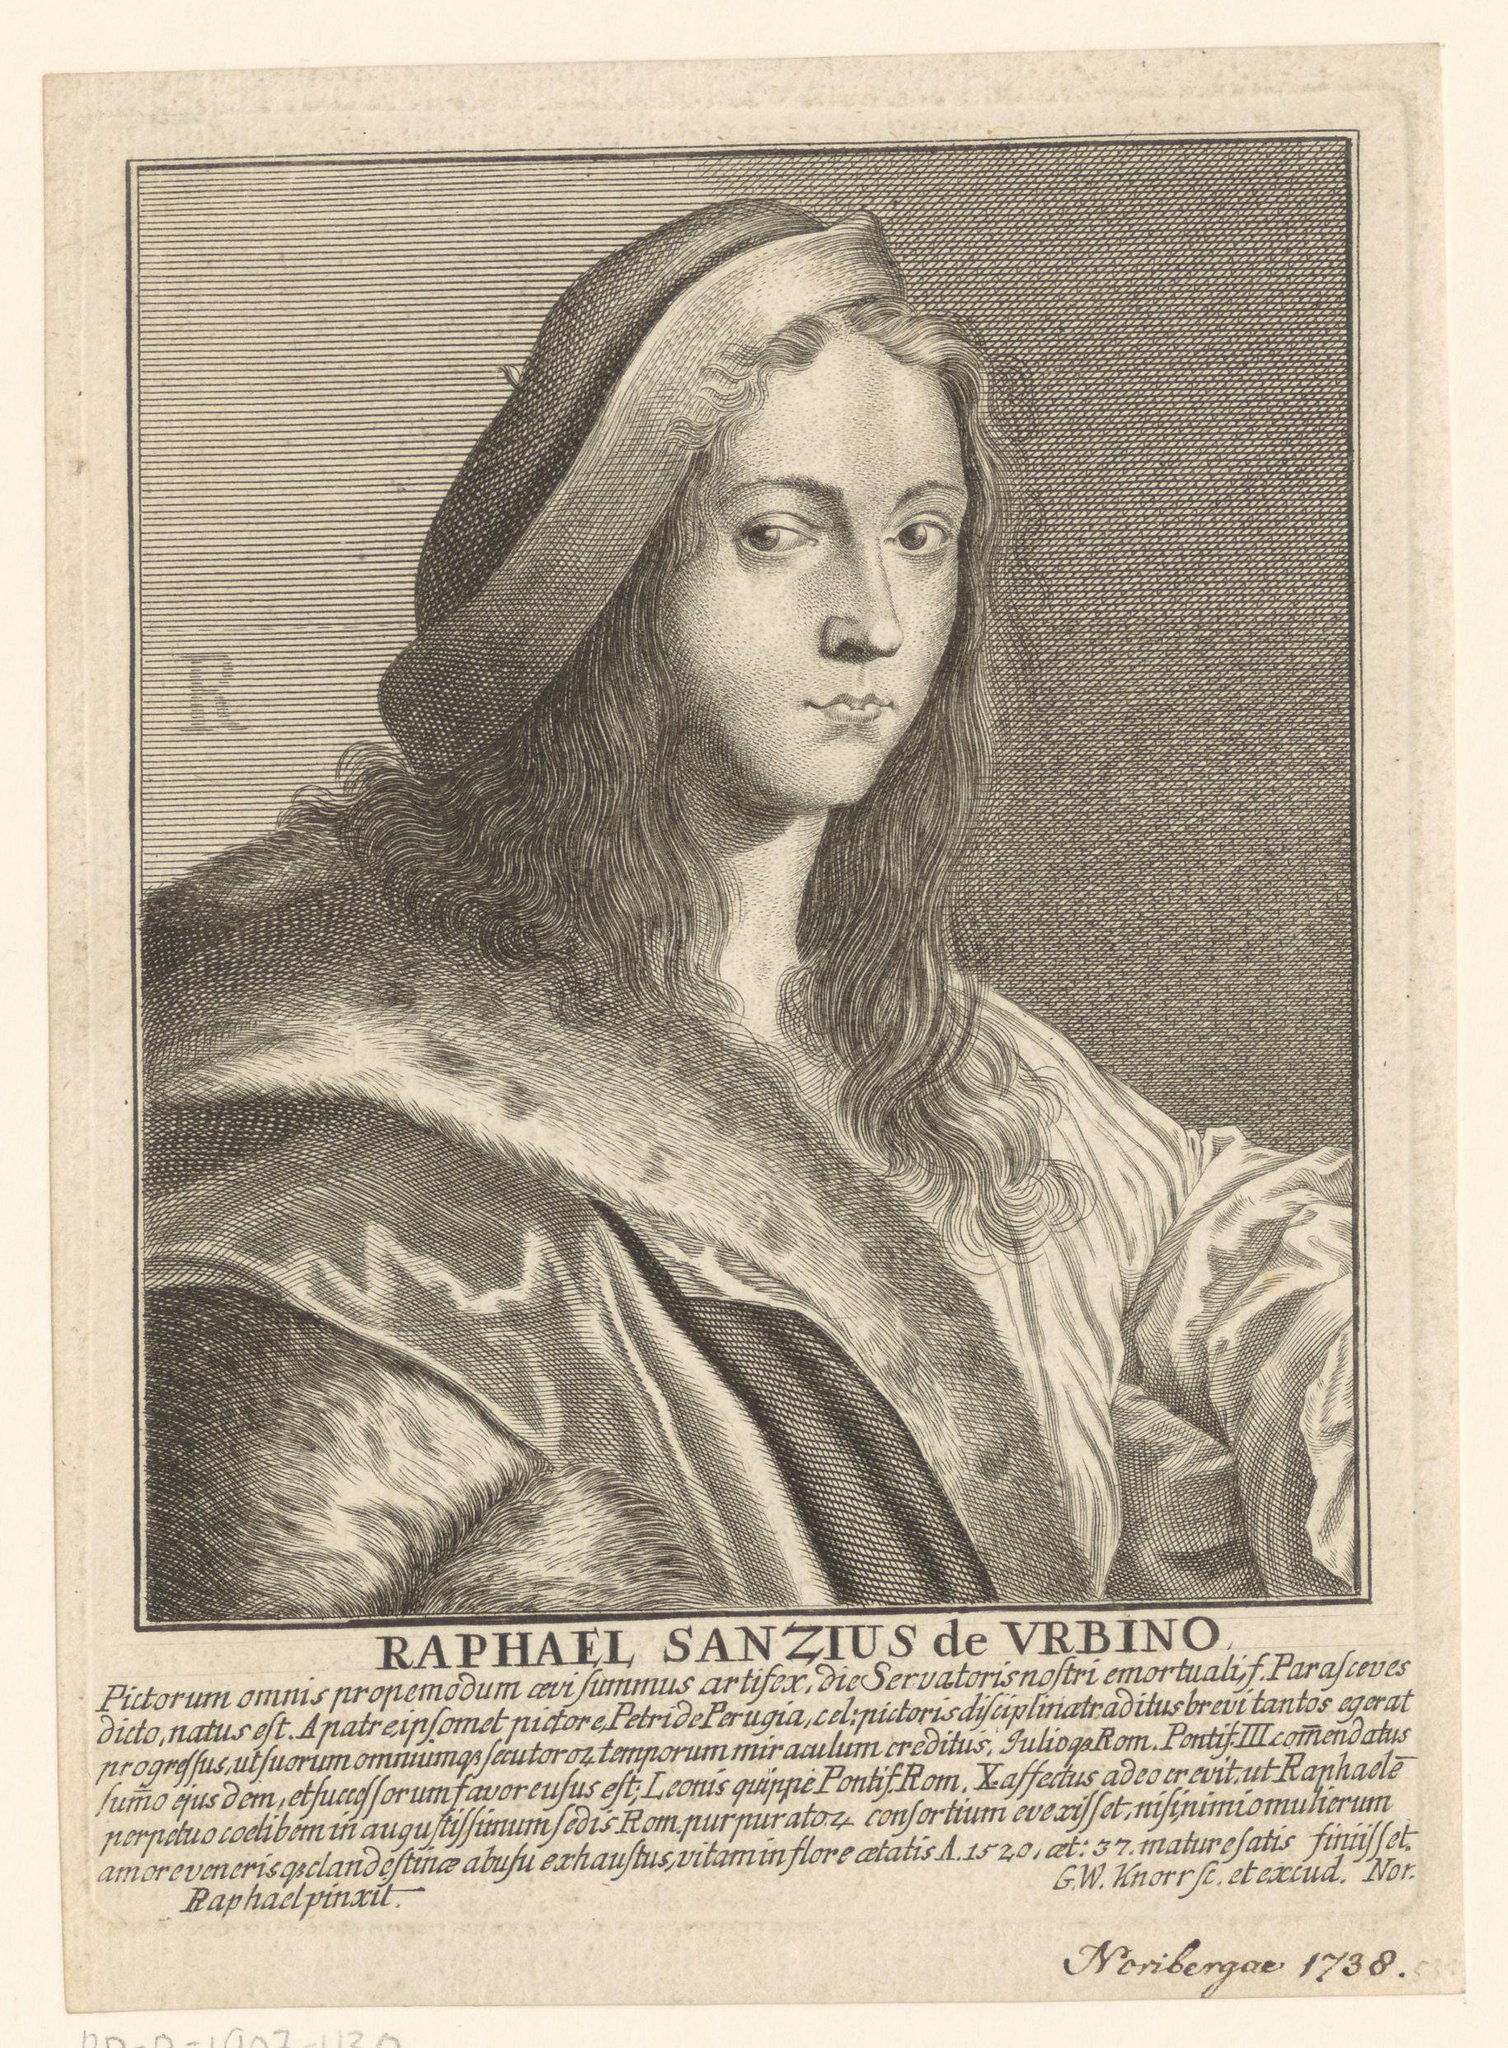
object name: print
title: Portret van Rafaël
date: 1738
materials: paper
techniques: engraving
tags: rome, painter, rafaël, historical persons, portrait, self-portrait of painter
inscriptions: collector's mark: Lugt 2228